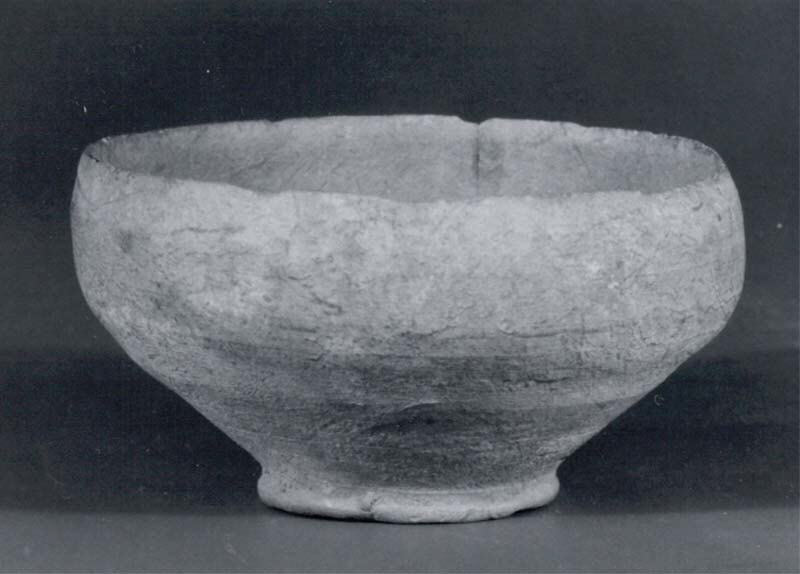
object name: bowl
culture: nabataean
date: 1-100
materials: ceramic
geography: levant